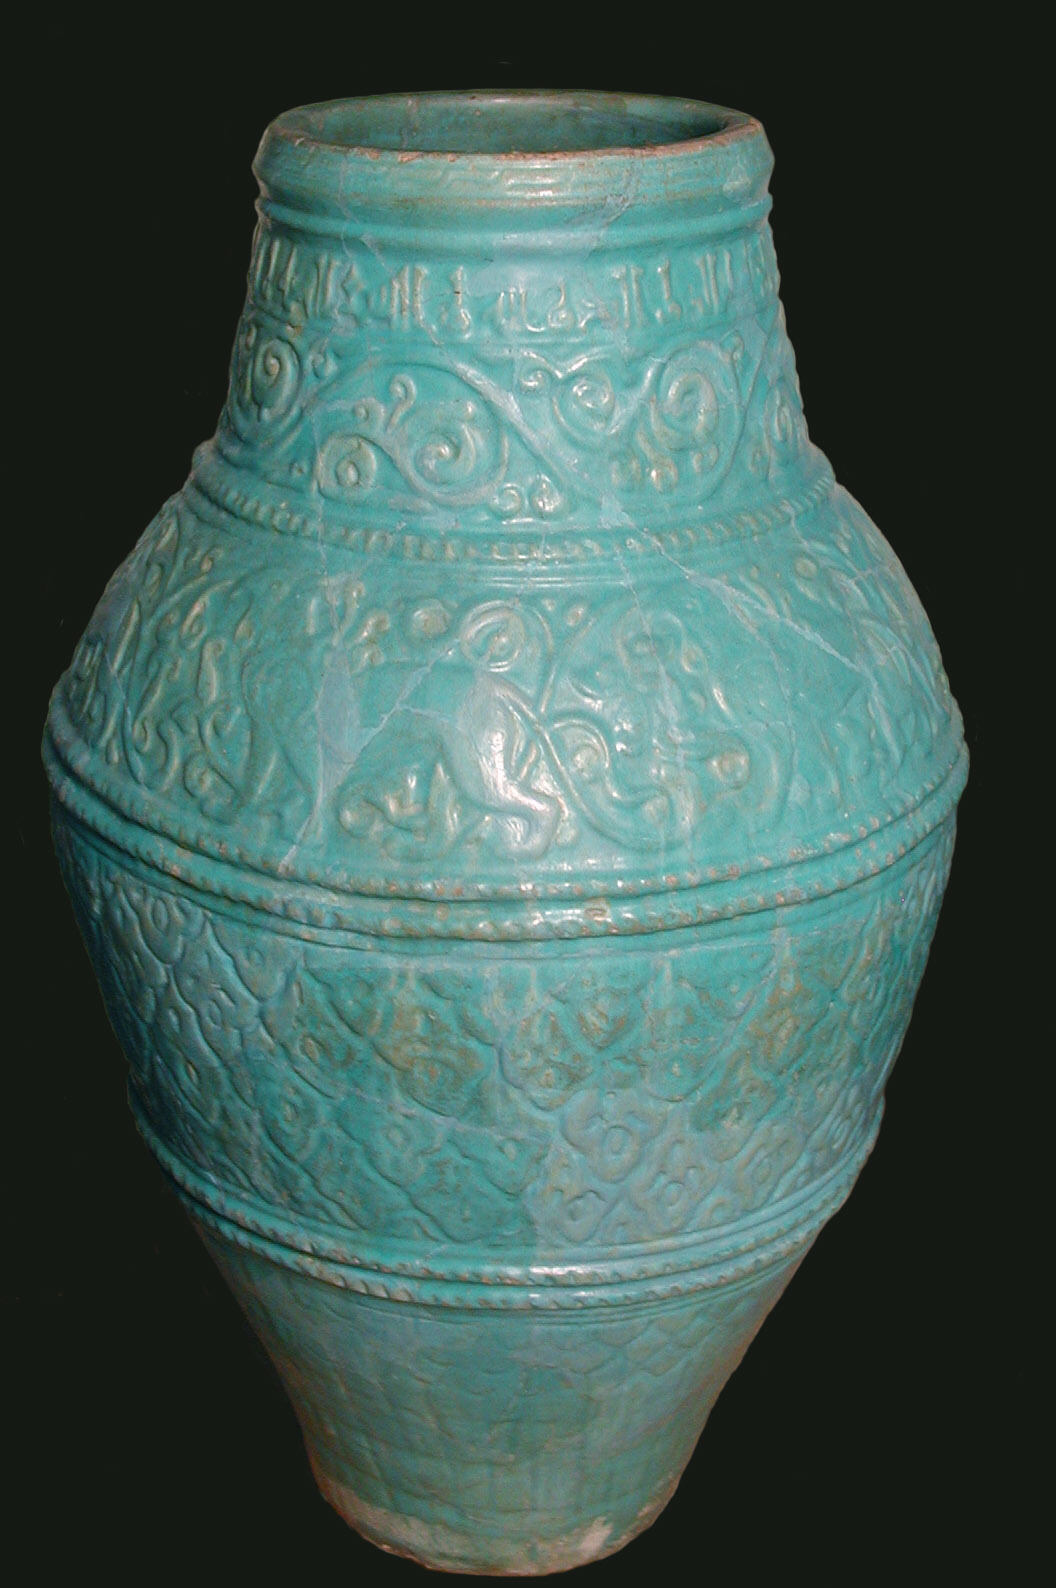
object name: vase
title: Large Turquoise Jar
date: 1101-1300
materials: earthenware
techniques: glazing, molding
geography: iran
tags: griffins